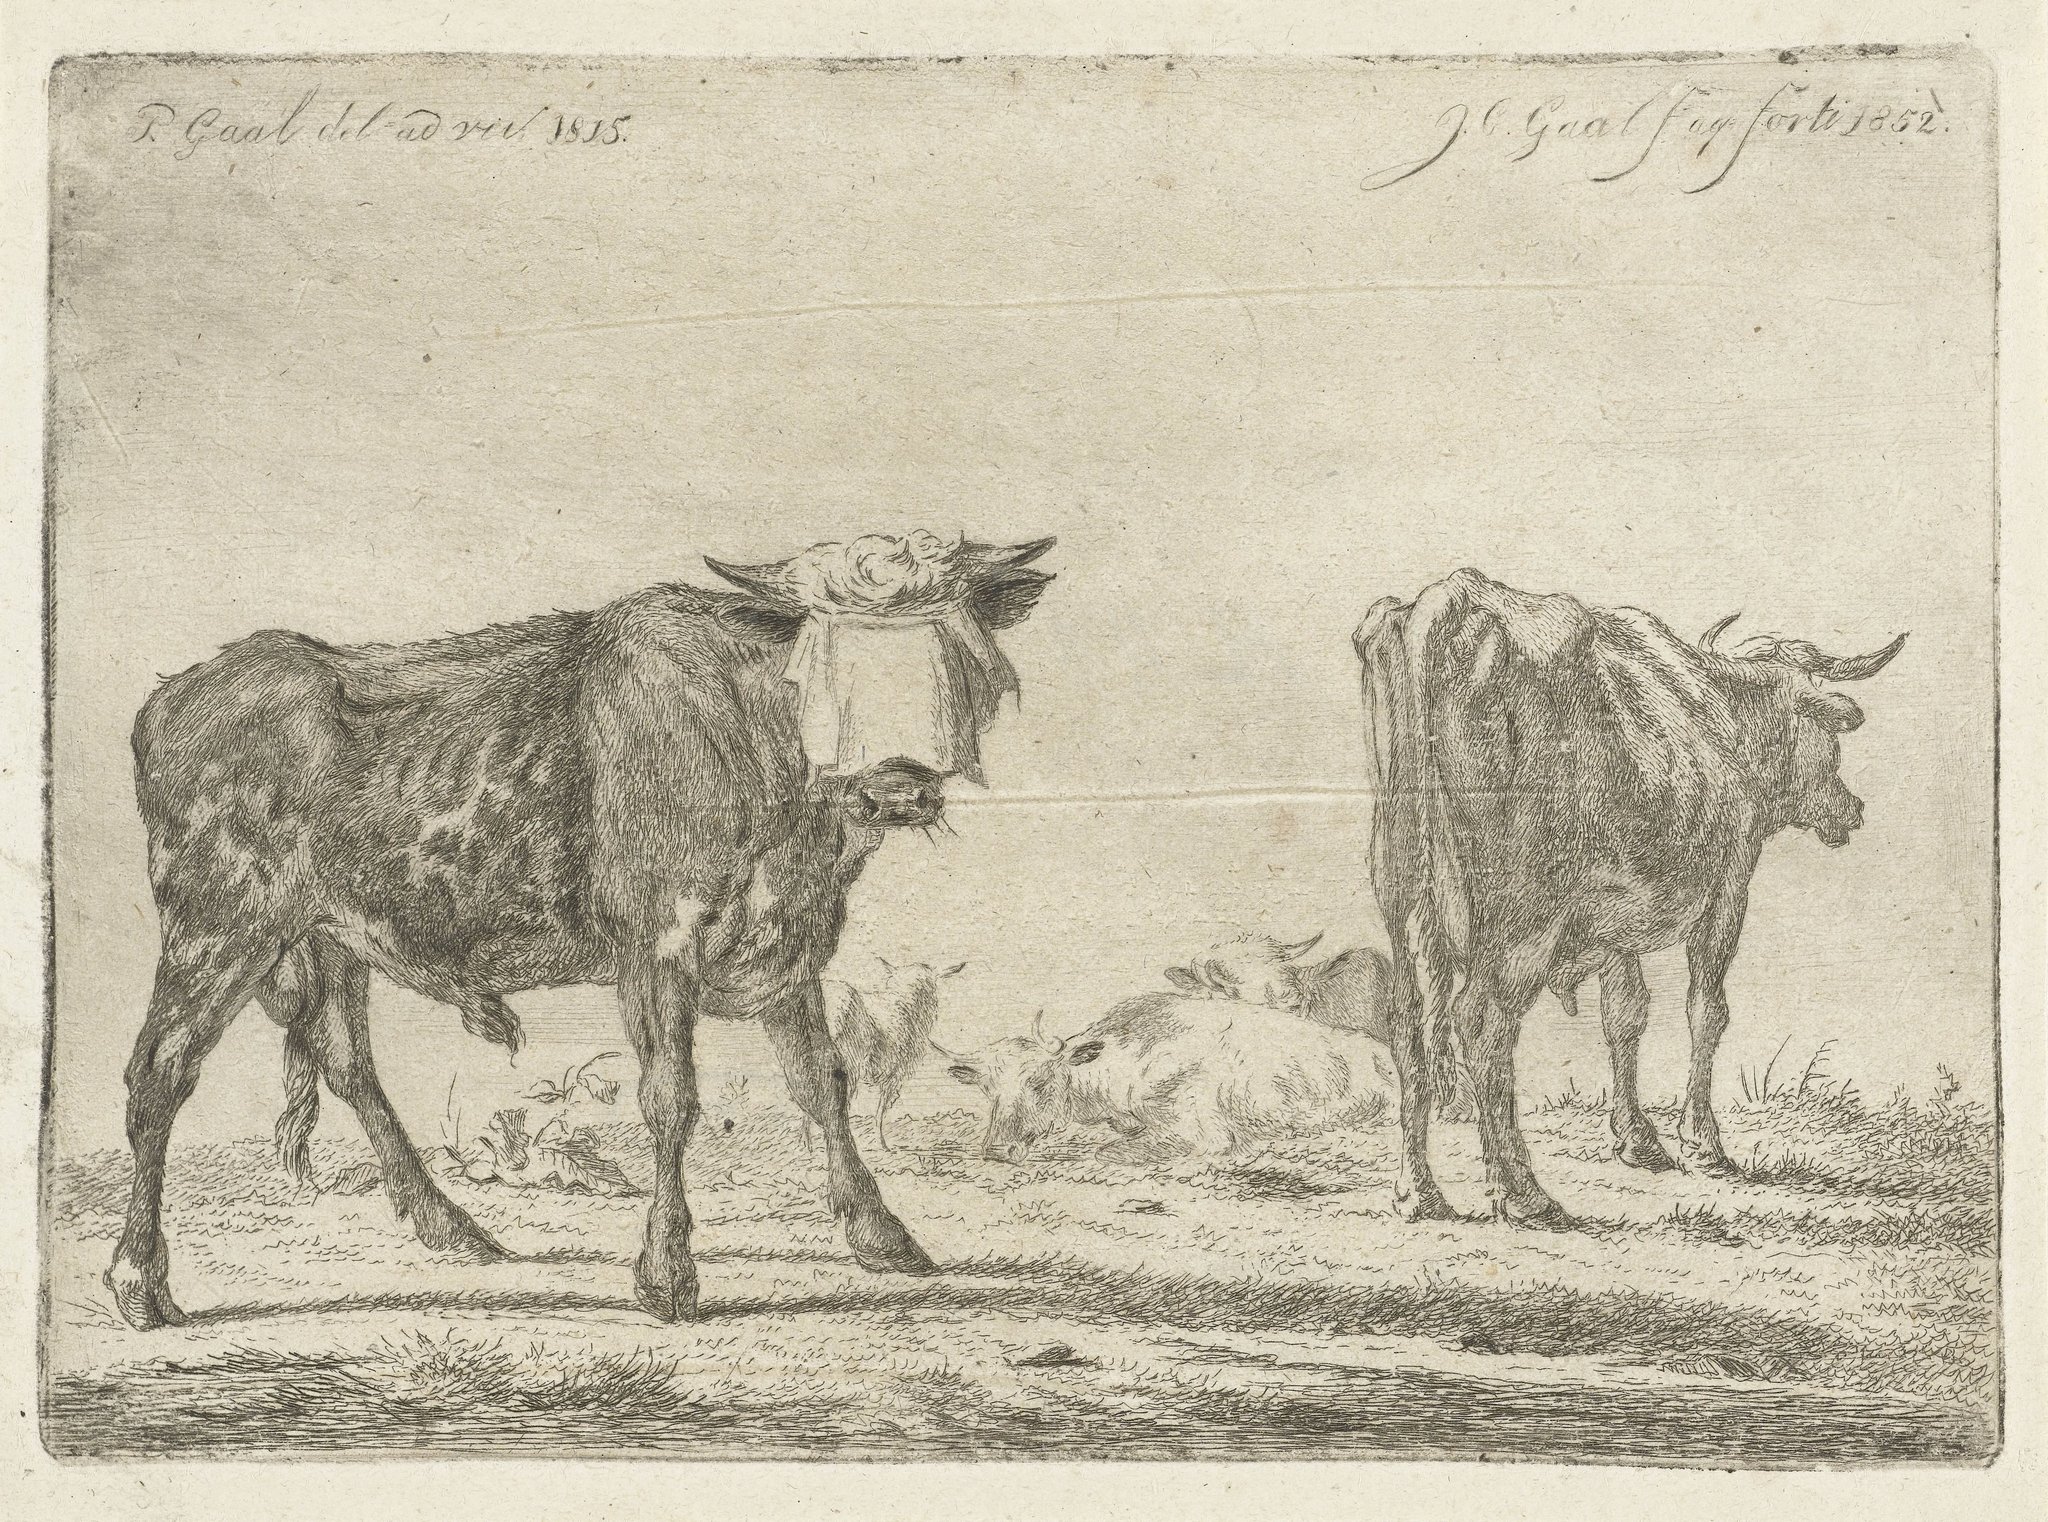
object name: print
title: Geblinddoekte stier bij kudde runderen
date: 1852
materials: paper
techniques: etching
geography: netherlands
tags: bovine cattle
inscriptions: collector's mark: Lugt 2228